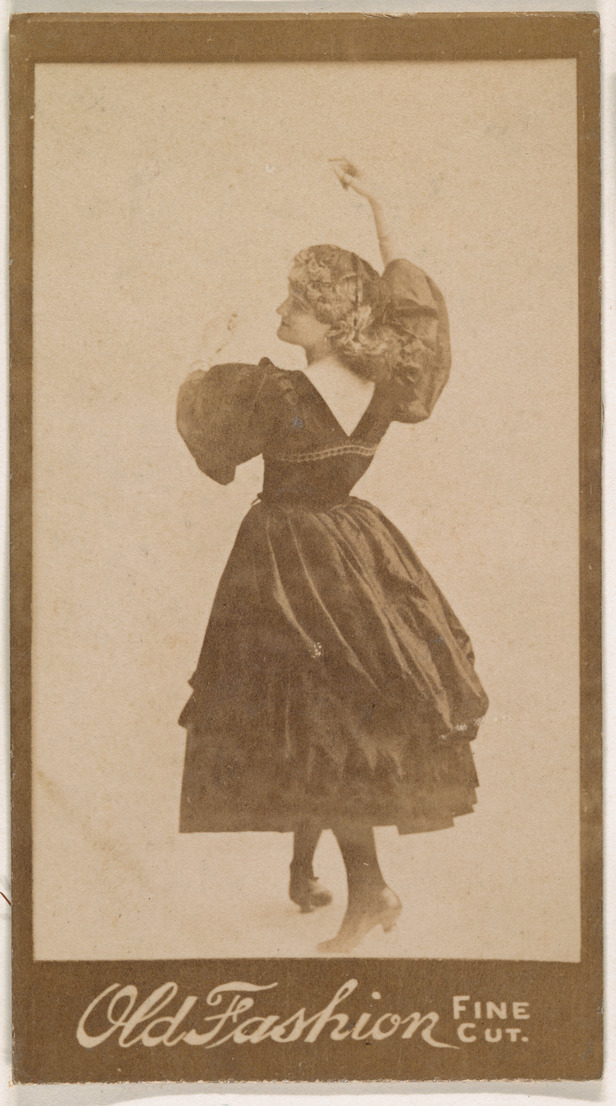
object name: photograph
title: Dancer, from the Actresses series (N664) promoting Old Fashion Fine Cut Tobacco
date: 1888-1890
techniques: albumen silver print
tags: portraits,women,dancers